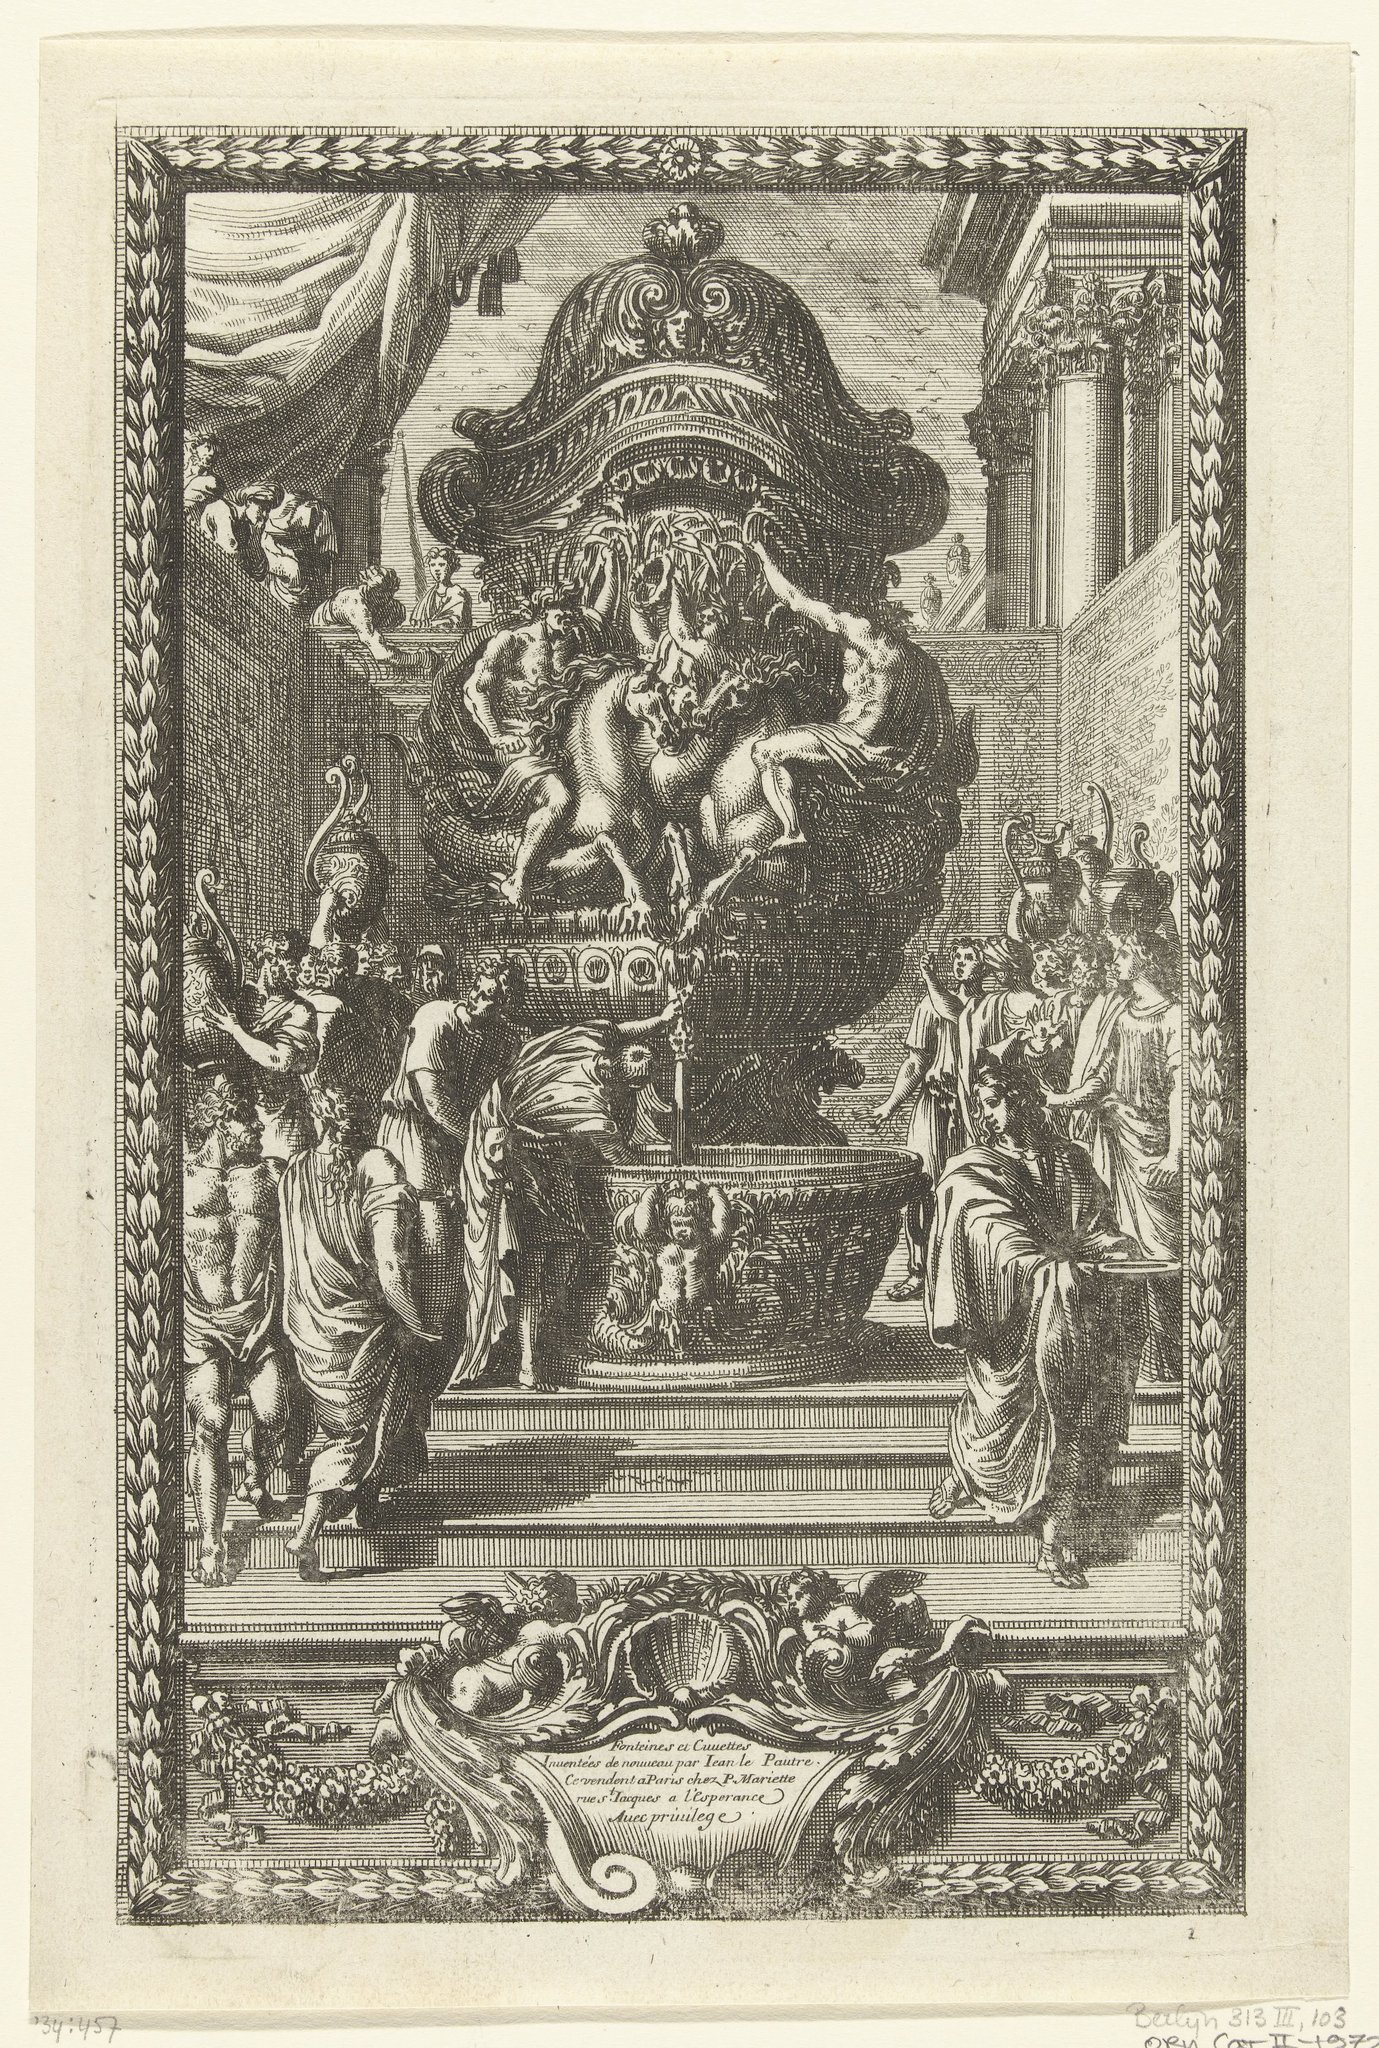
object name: ornament print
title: Fonteines et Cuuettes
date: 1657-1661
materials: paper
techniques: etching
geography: france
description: Fontein met bassin van voren gezien, geplaatst in een buitenruimte en omringd door figuren.